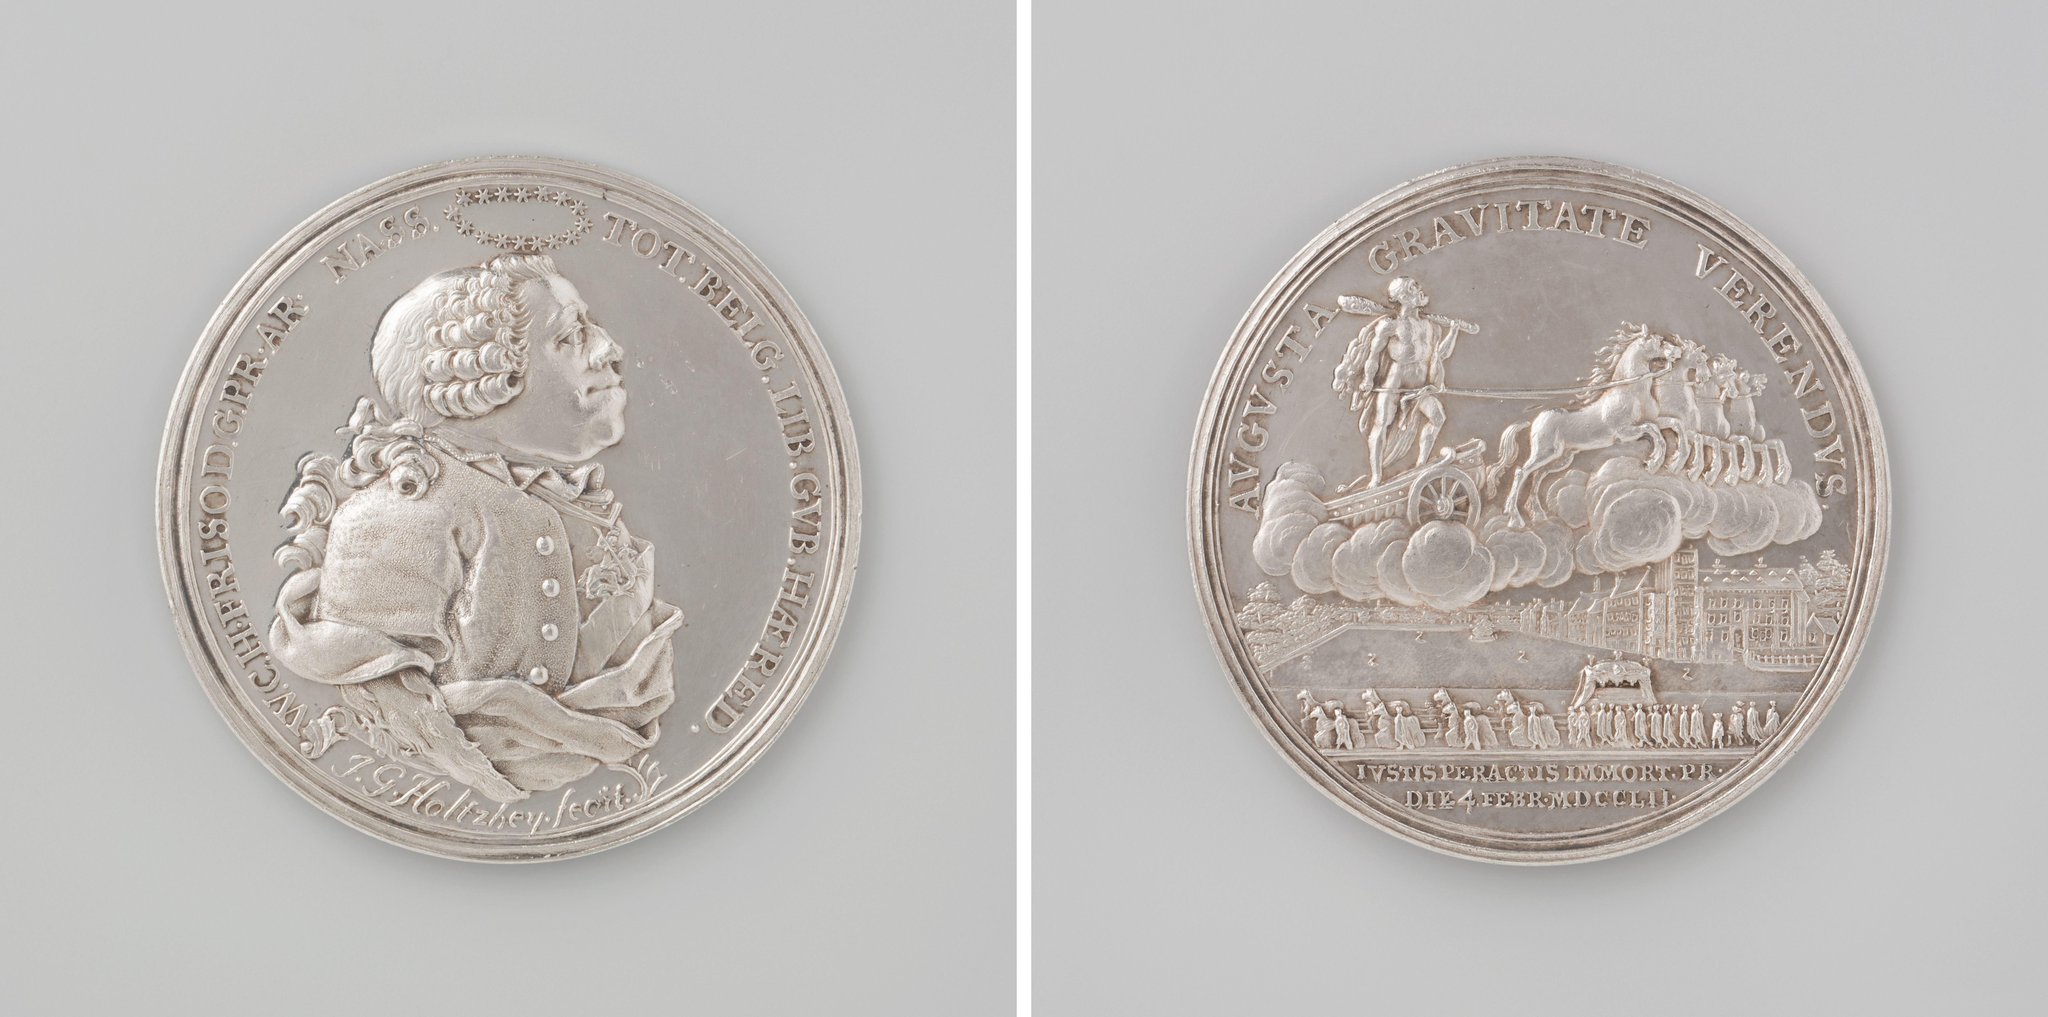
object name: history medal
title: Begrafenis van Willem IV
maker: johan george holtzhey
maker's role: mintmaster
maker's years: 1726-1808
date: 1752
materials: silver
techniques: striking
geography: amsterdam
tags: the hague, willem iv (prins van oranje-nassau)